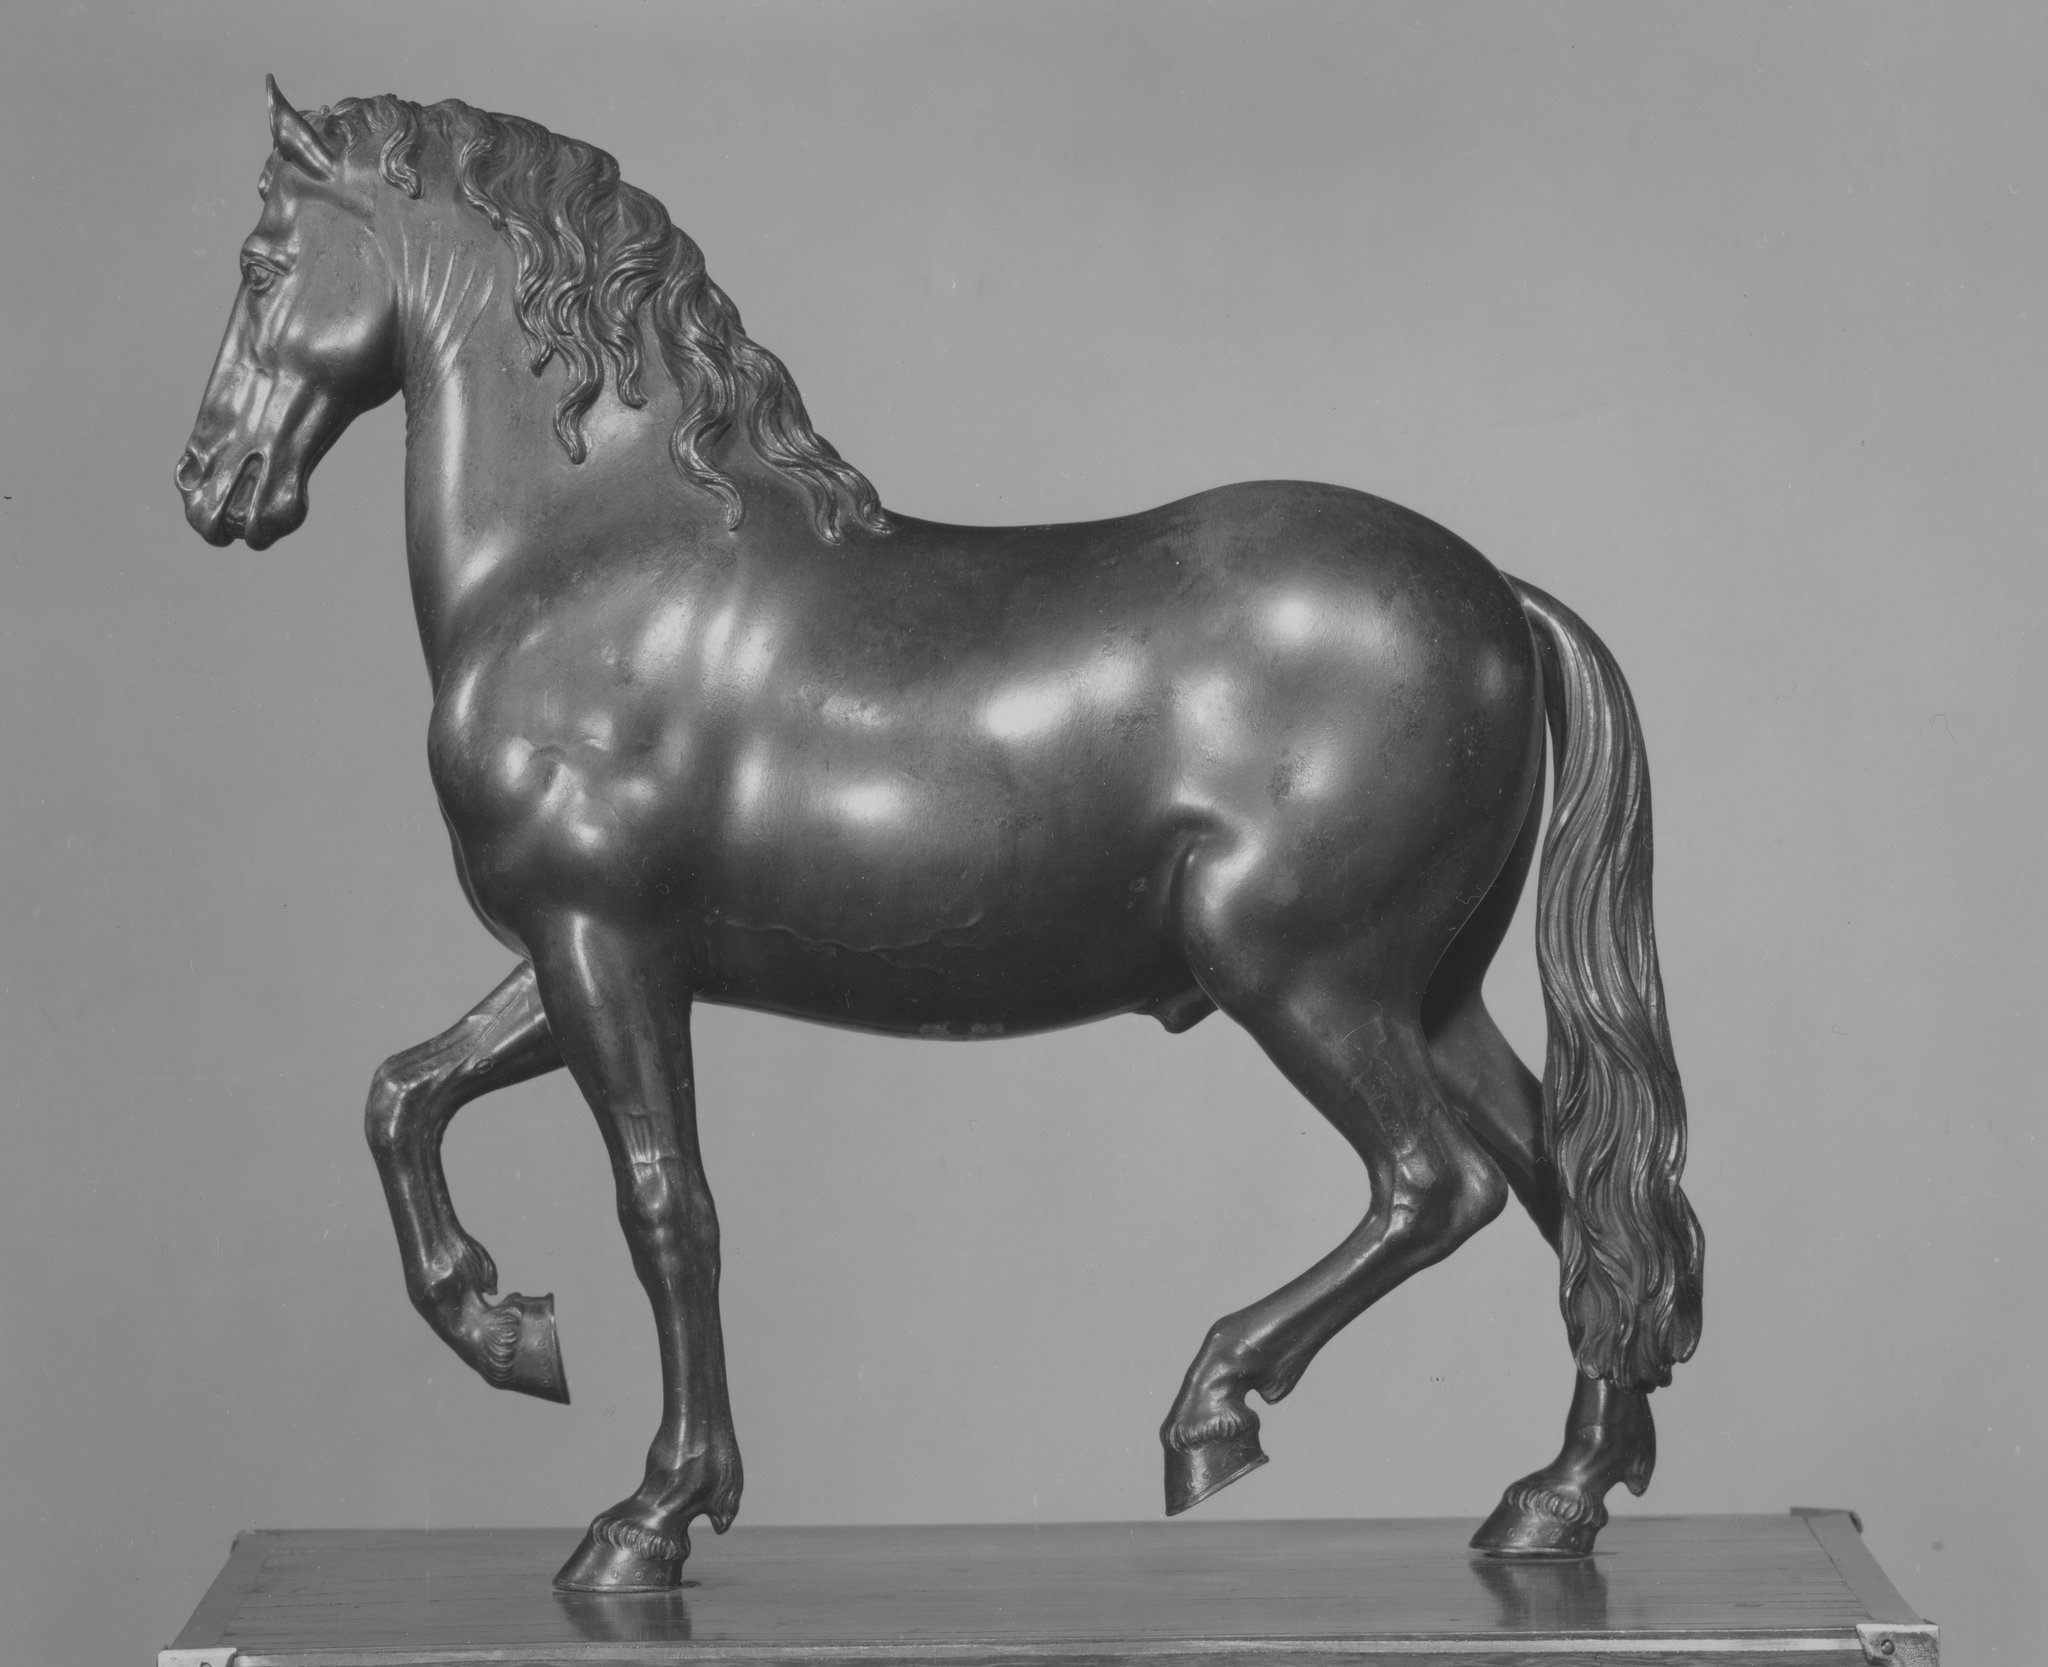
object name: statuette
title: Horse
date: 1667-1733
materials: bronze, lacquer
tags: horses